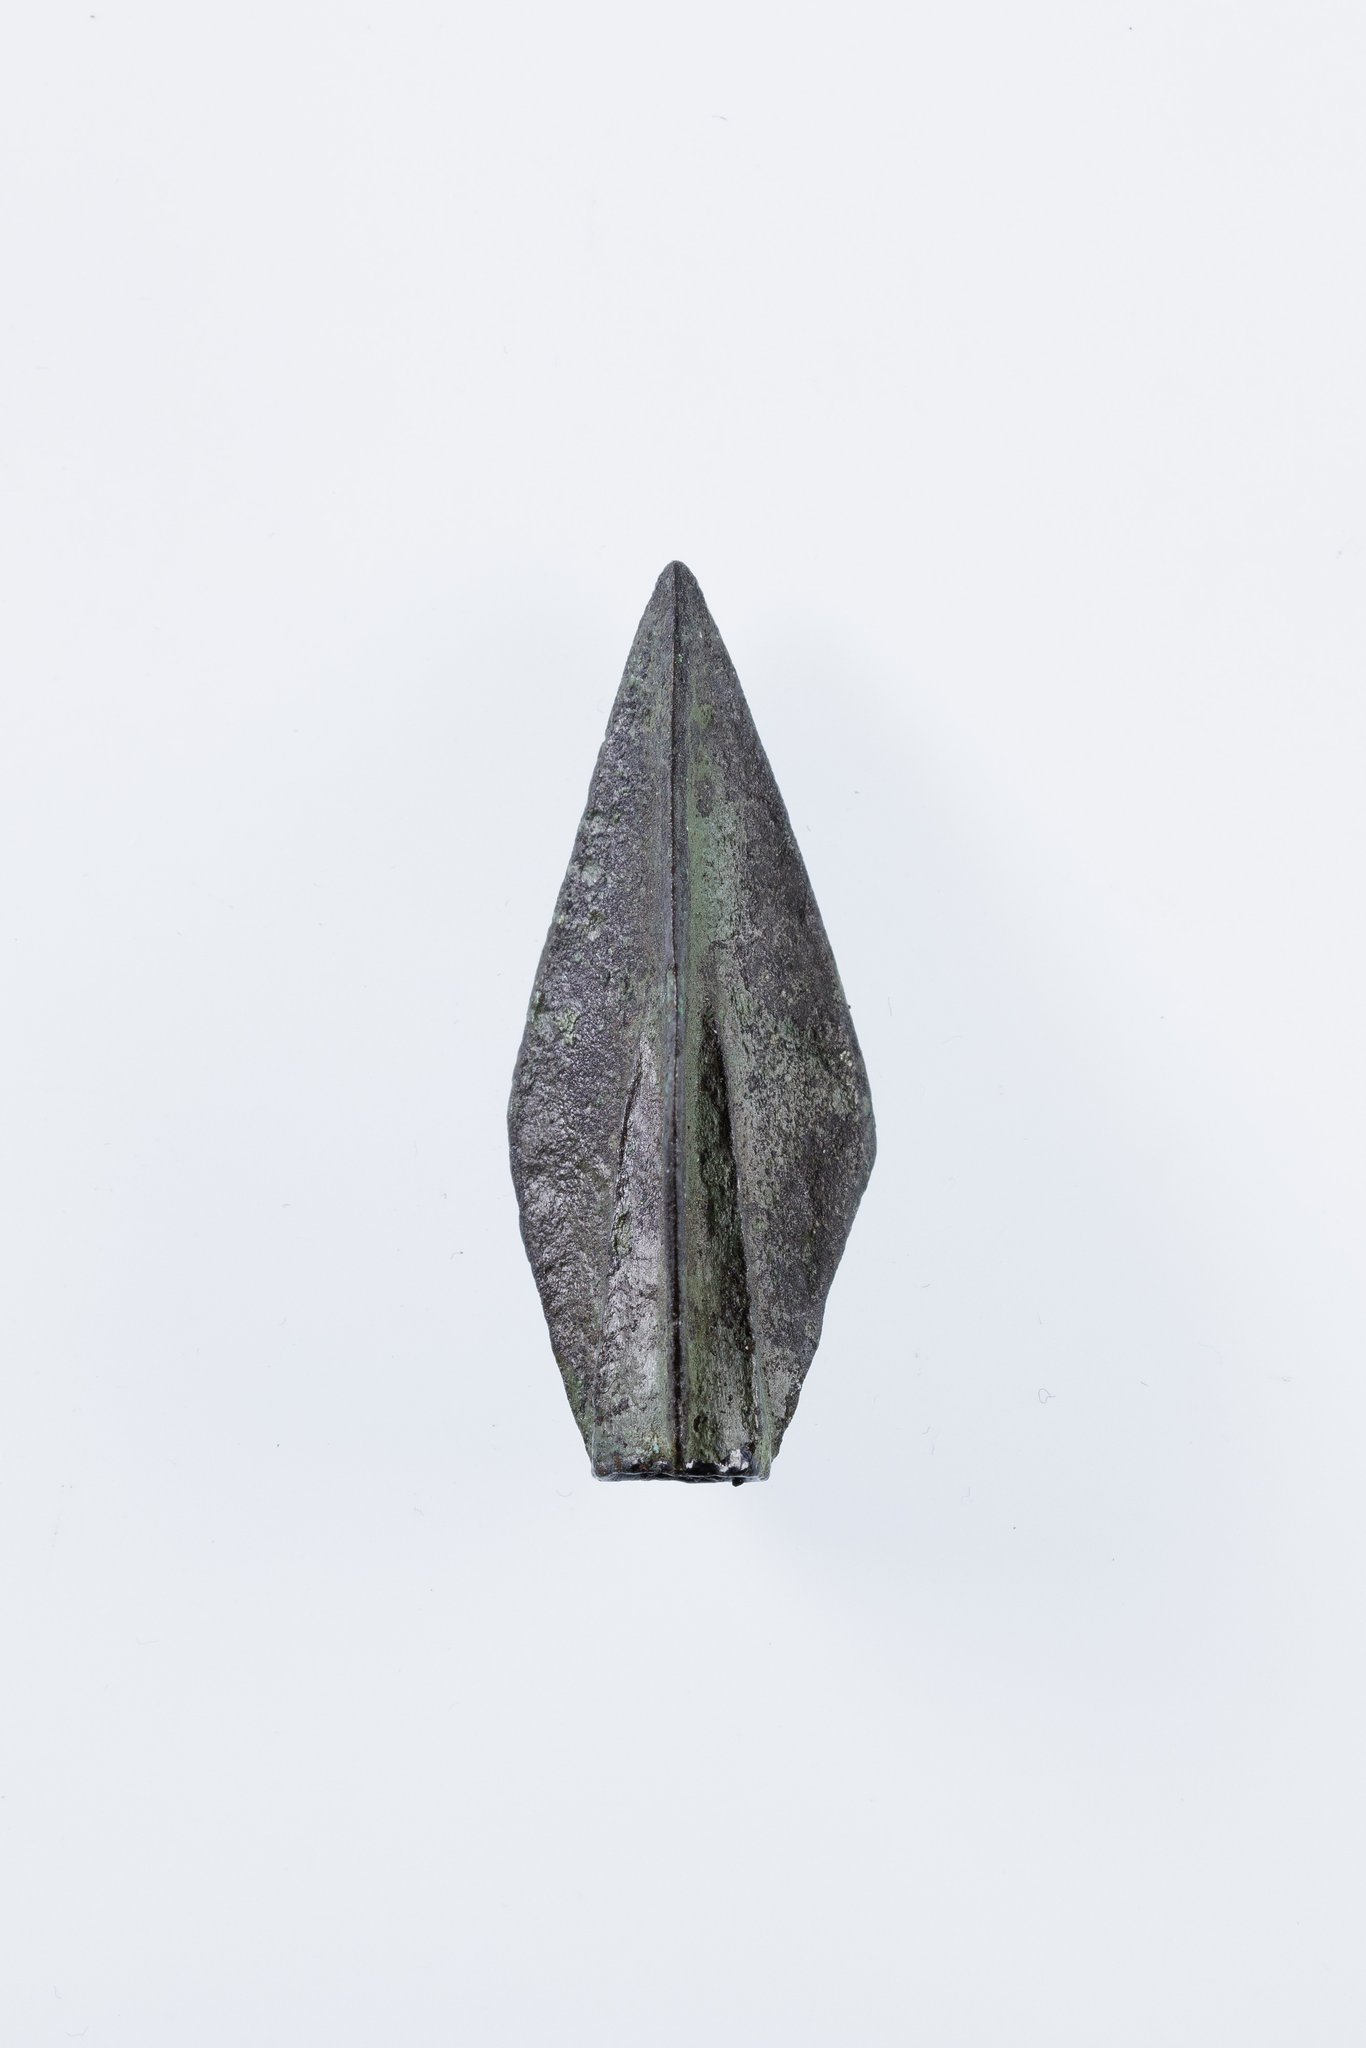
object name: arrow point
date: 664-525 BCE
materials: bronze, copper alloy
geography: egypt